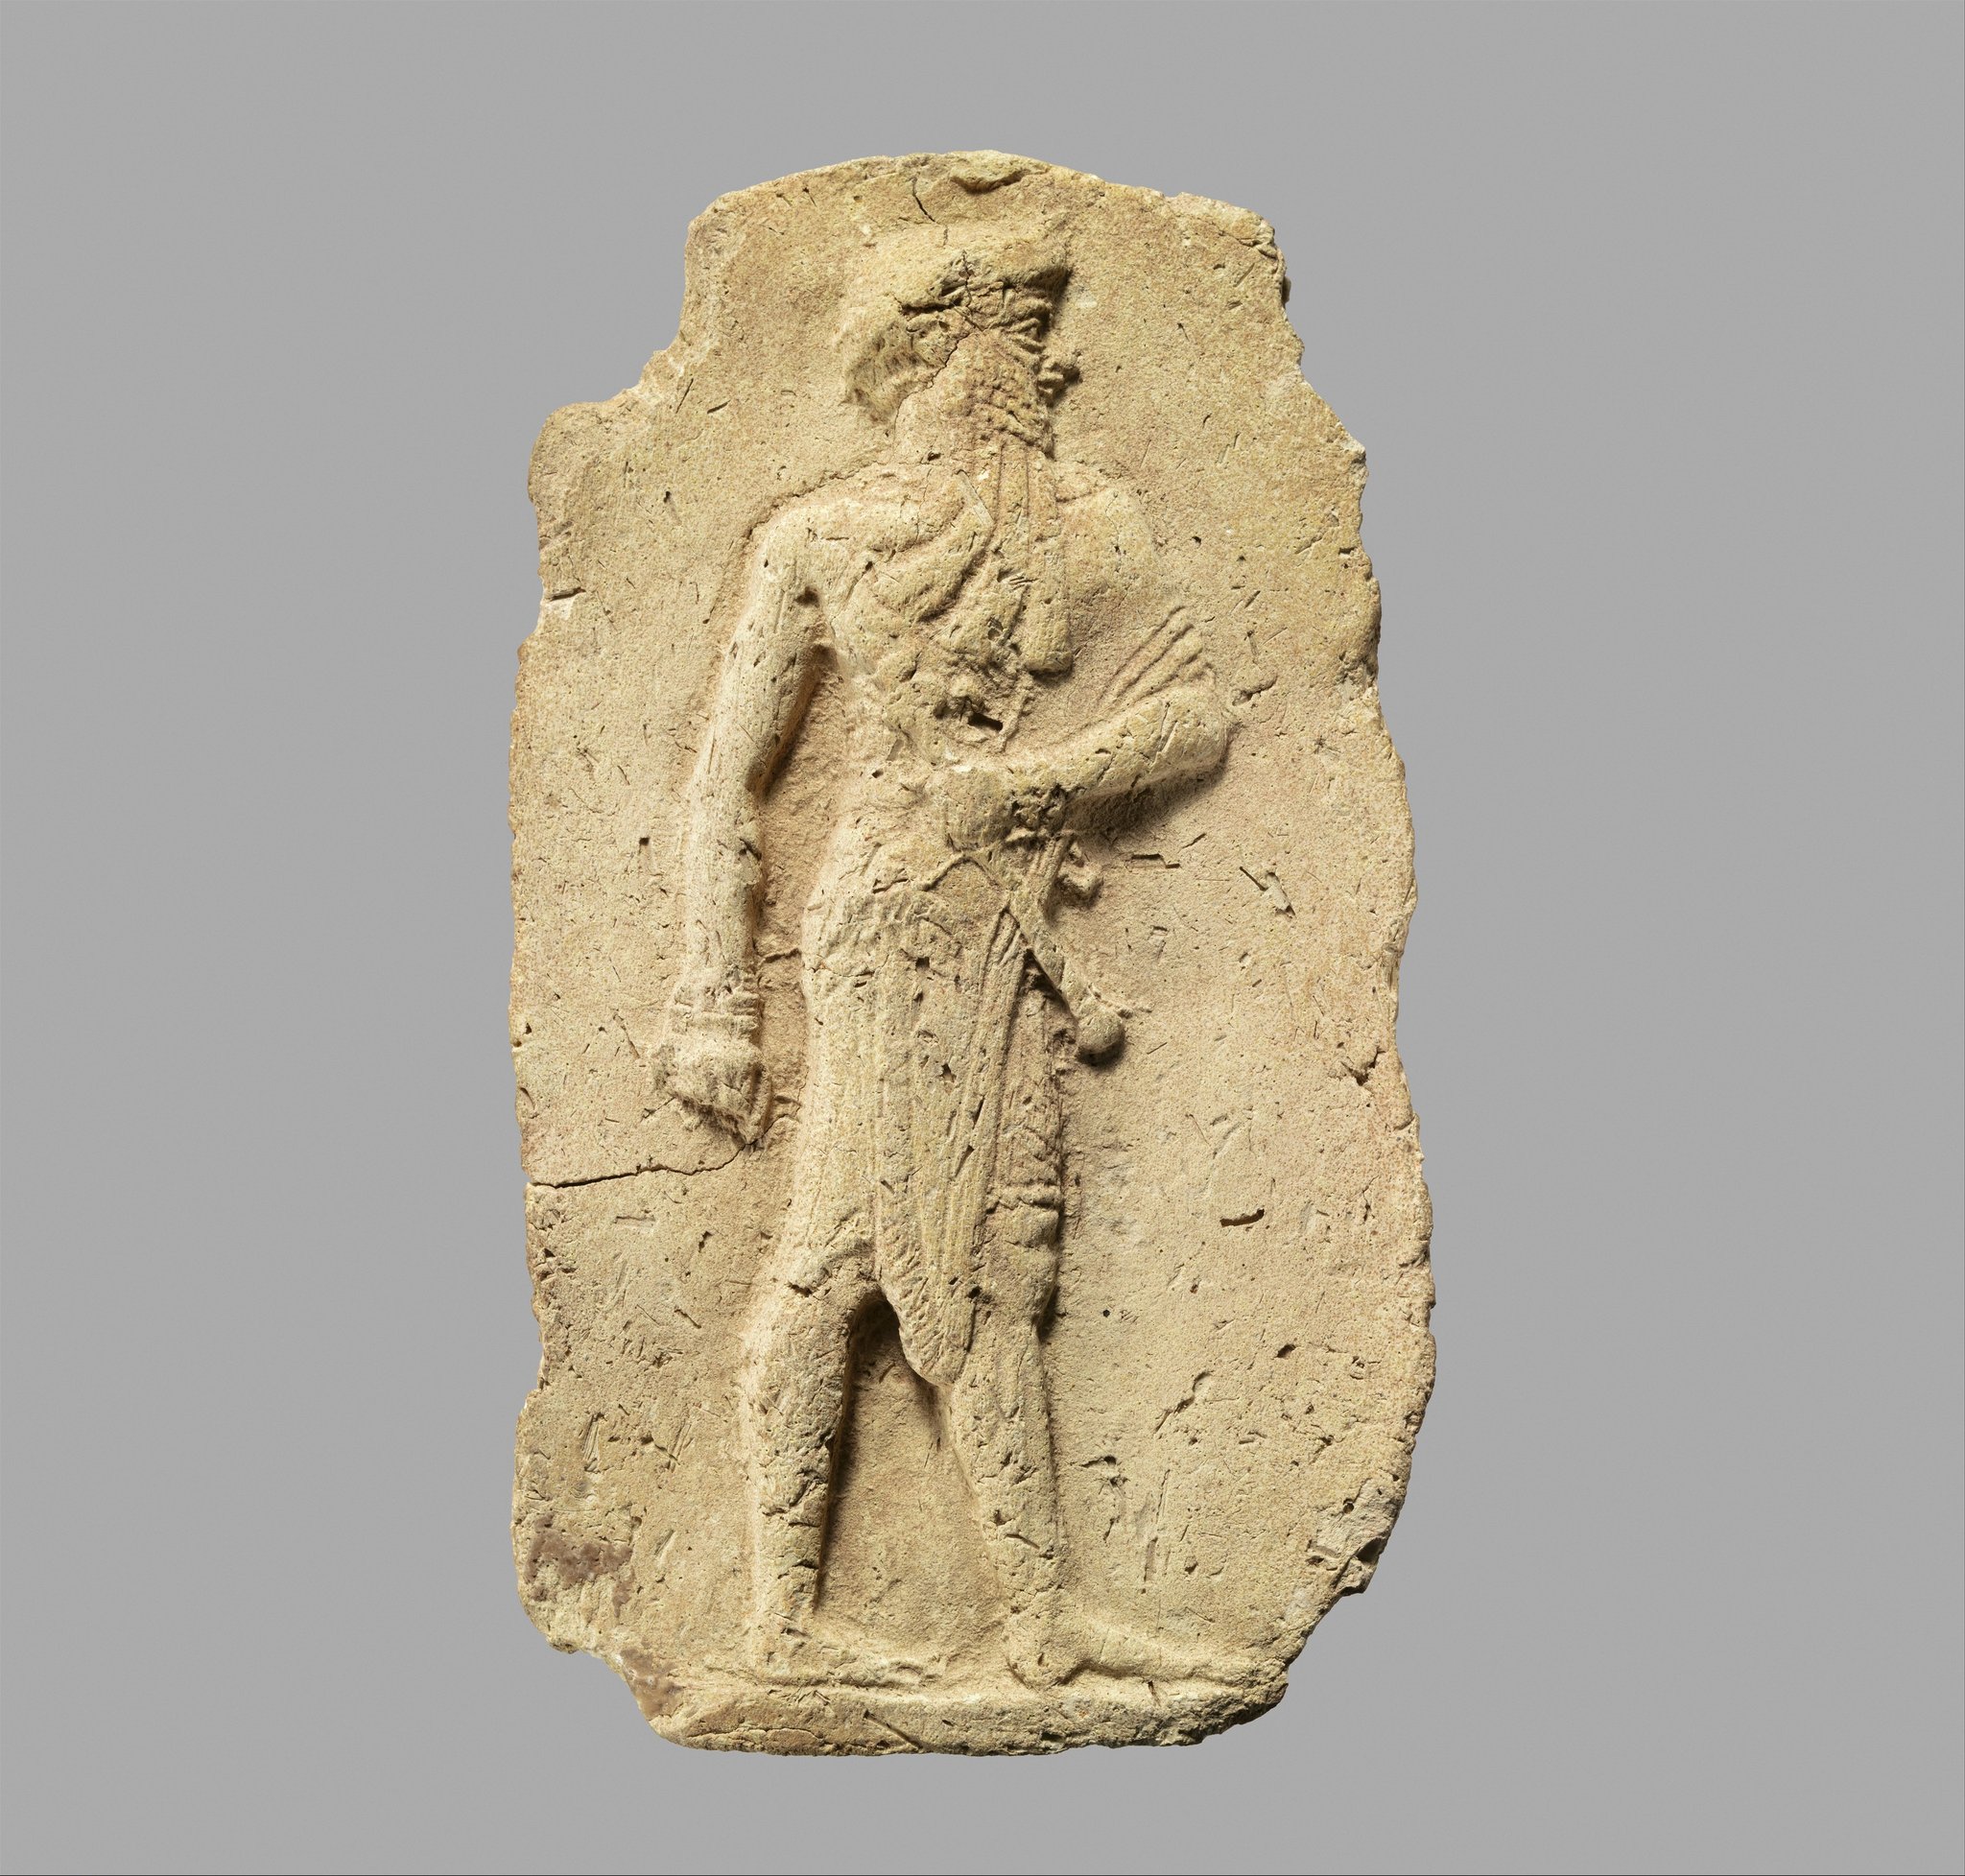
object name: relief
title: Molded plaque: king or a god carrying a mace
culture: isin-larsa–old babylonian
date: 2000-1700 BCE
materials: ceramic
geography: southern mesopotamia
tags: weapons,men